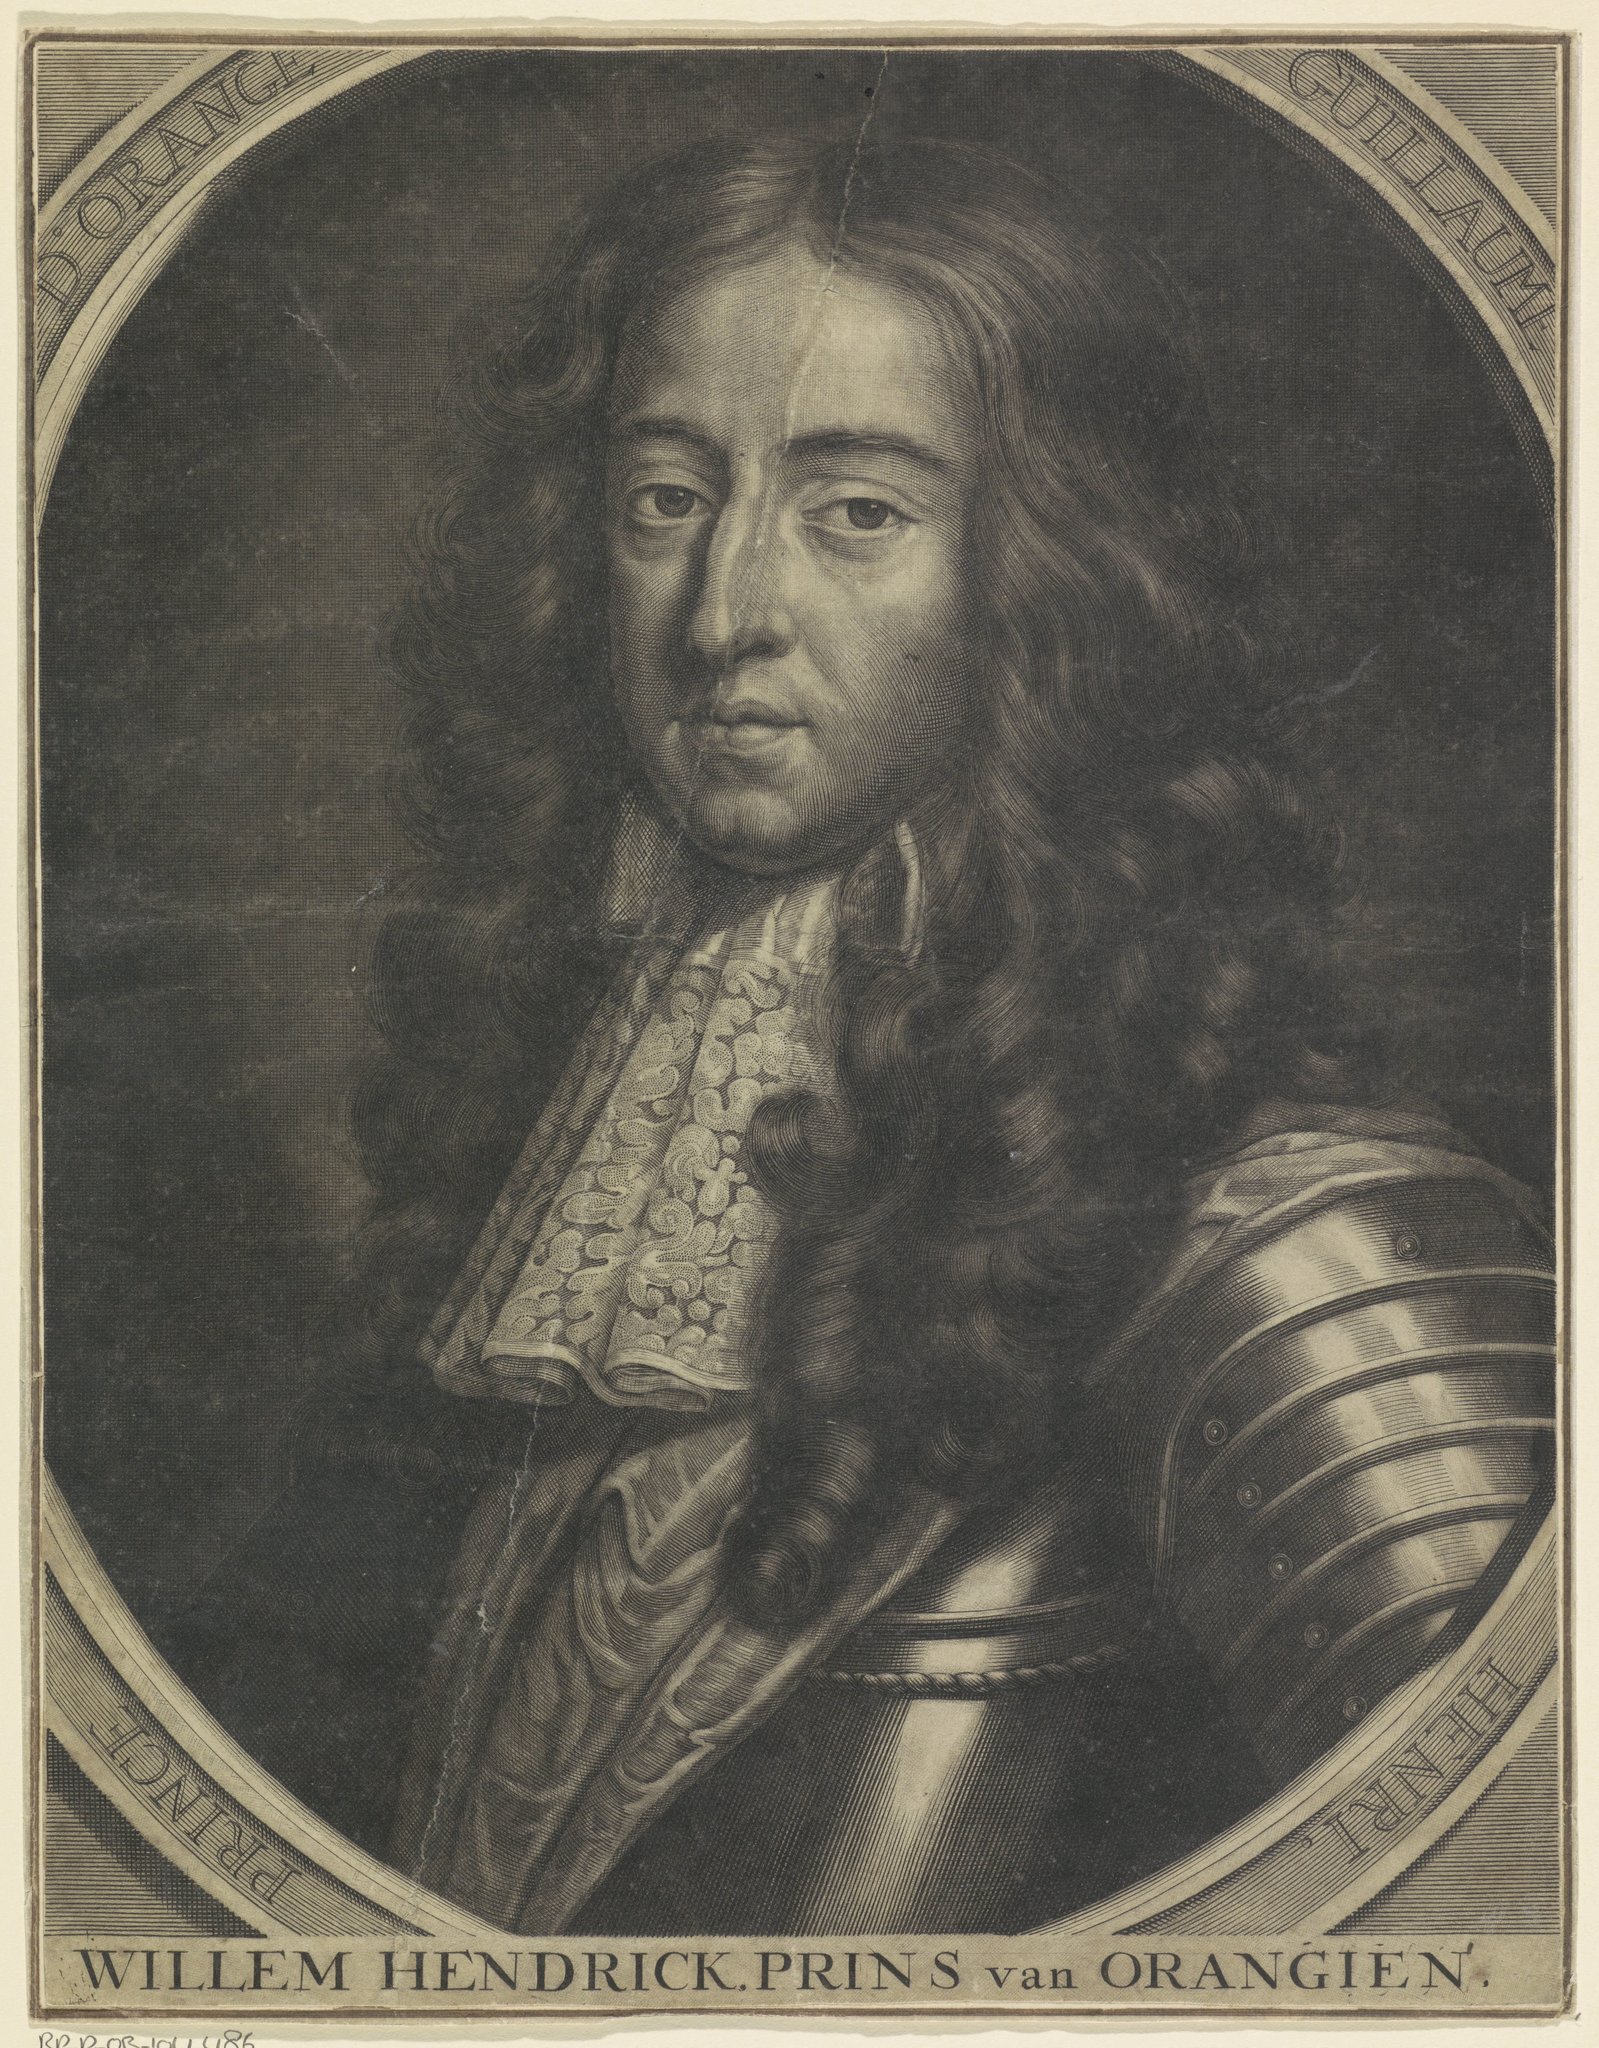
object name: print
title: Portret van Willem III, prins van Oranje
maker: Anonymous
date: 1670-1749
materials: paper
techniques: mezzotint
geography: low countries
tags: william iii (prince of orange and king of england, scotland, and ireland)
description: De hier vermelde titel verwijst naar de hoogst verkregen titel van de geportretteerde, niet per se naar de titel die de geportretteerde op deze voorstelling draagt.